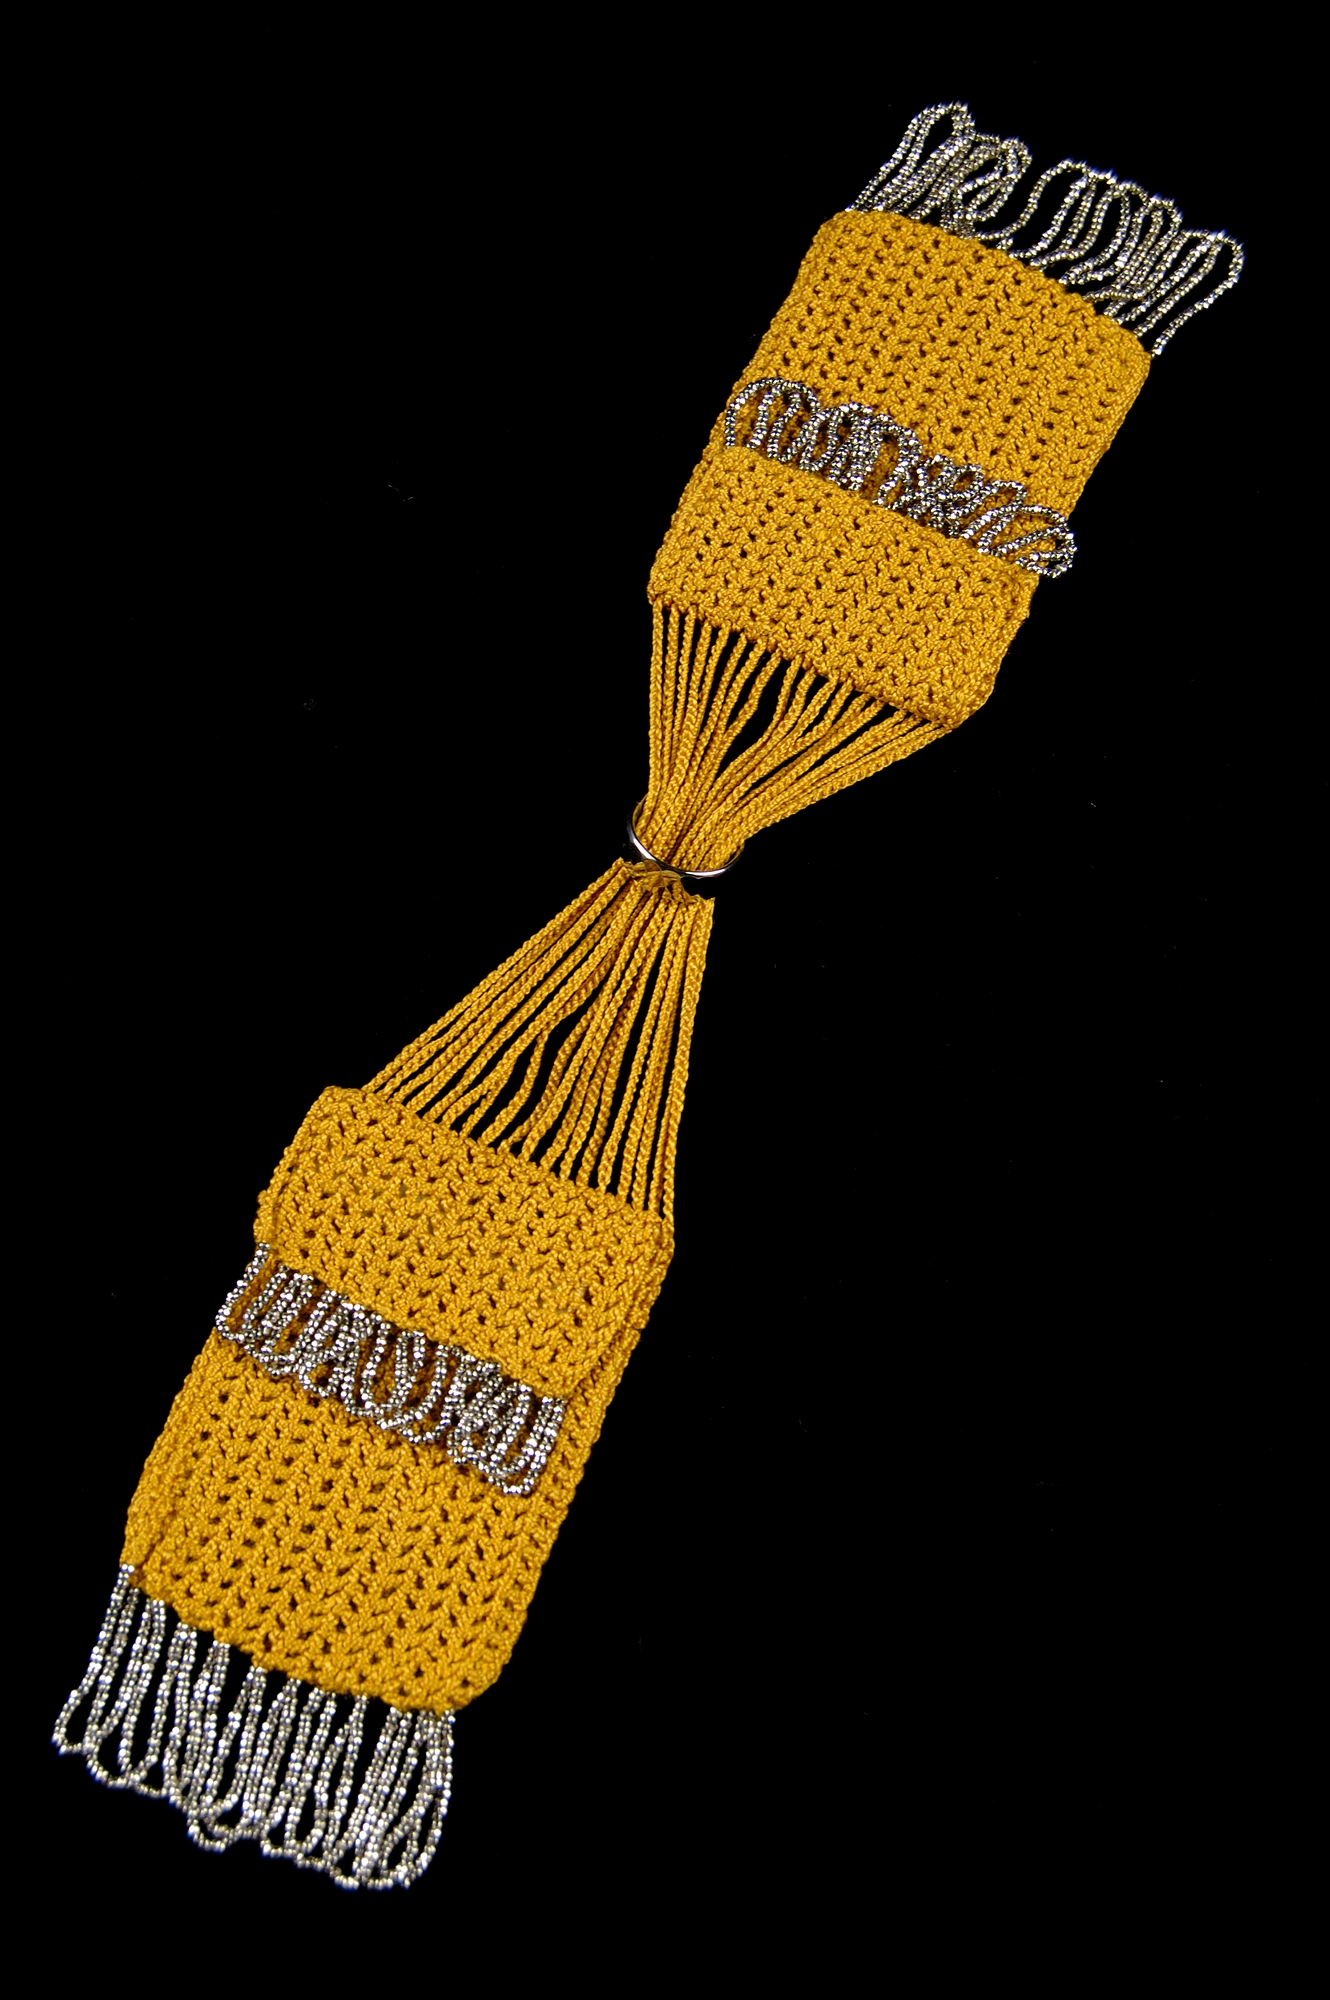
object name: miser's purse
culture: american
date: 1840-1860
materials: cotton, metal